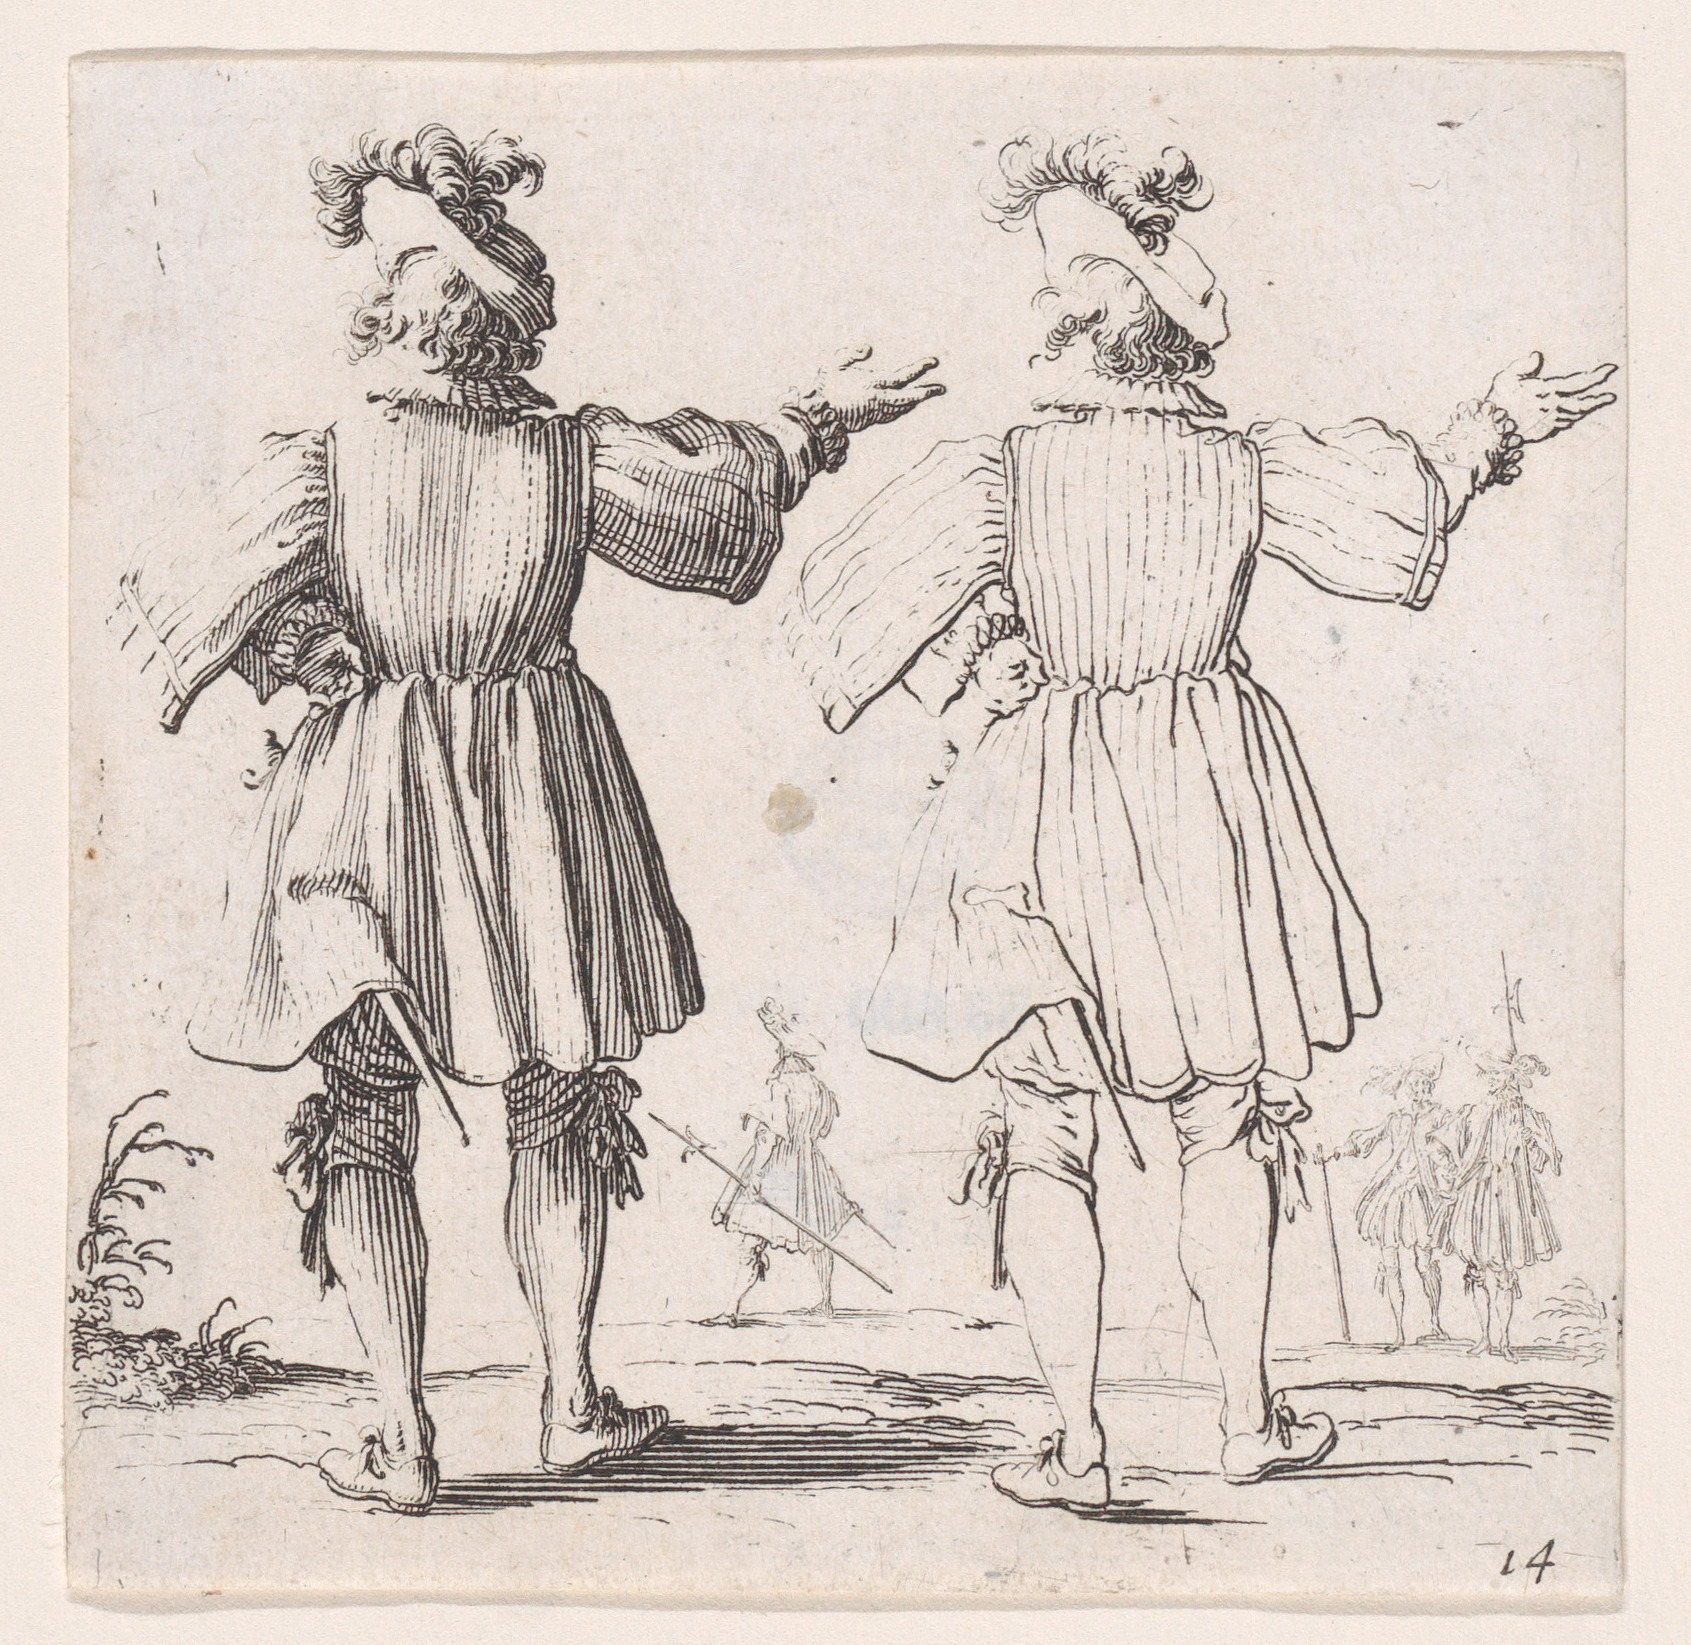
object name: print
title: L'Officier a la Collerette Vu de Dos (The Officer with the Hackle Seen from Behind), plate 14 from "Varie Figure" (Various Figures)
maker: jacques callot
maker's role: artist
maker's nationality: french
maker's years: 1592-1635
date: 1620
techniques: etching